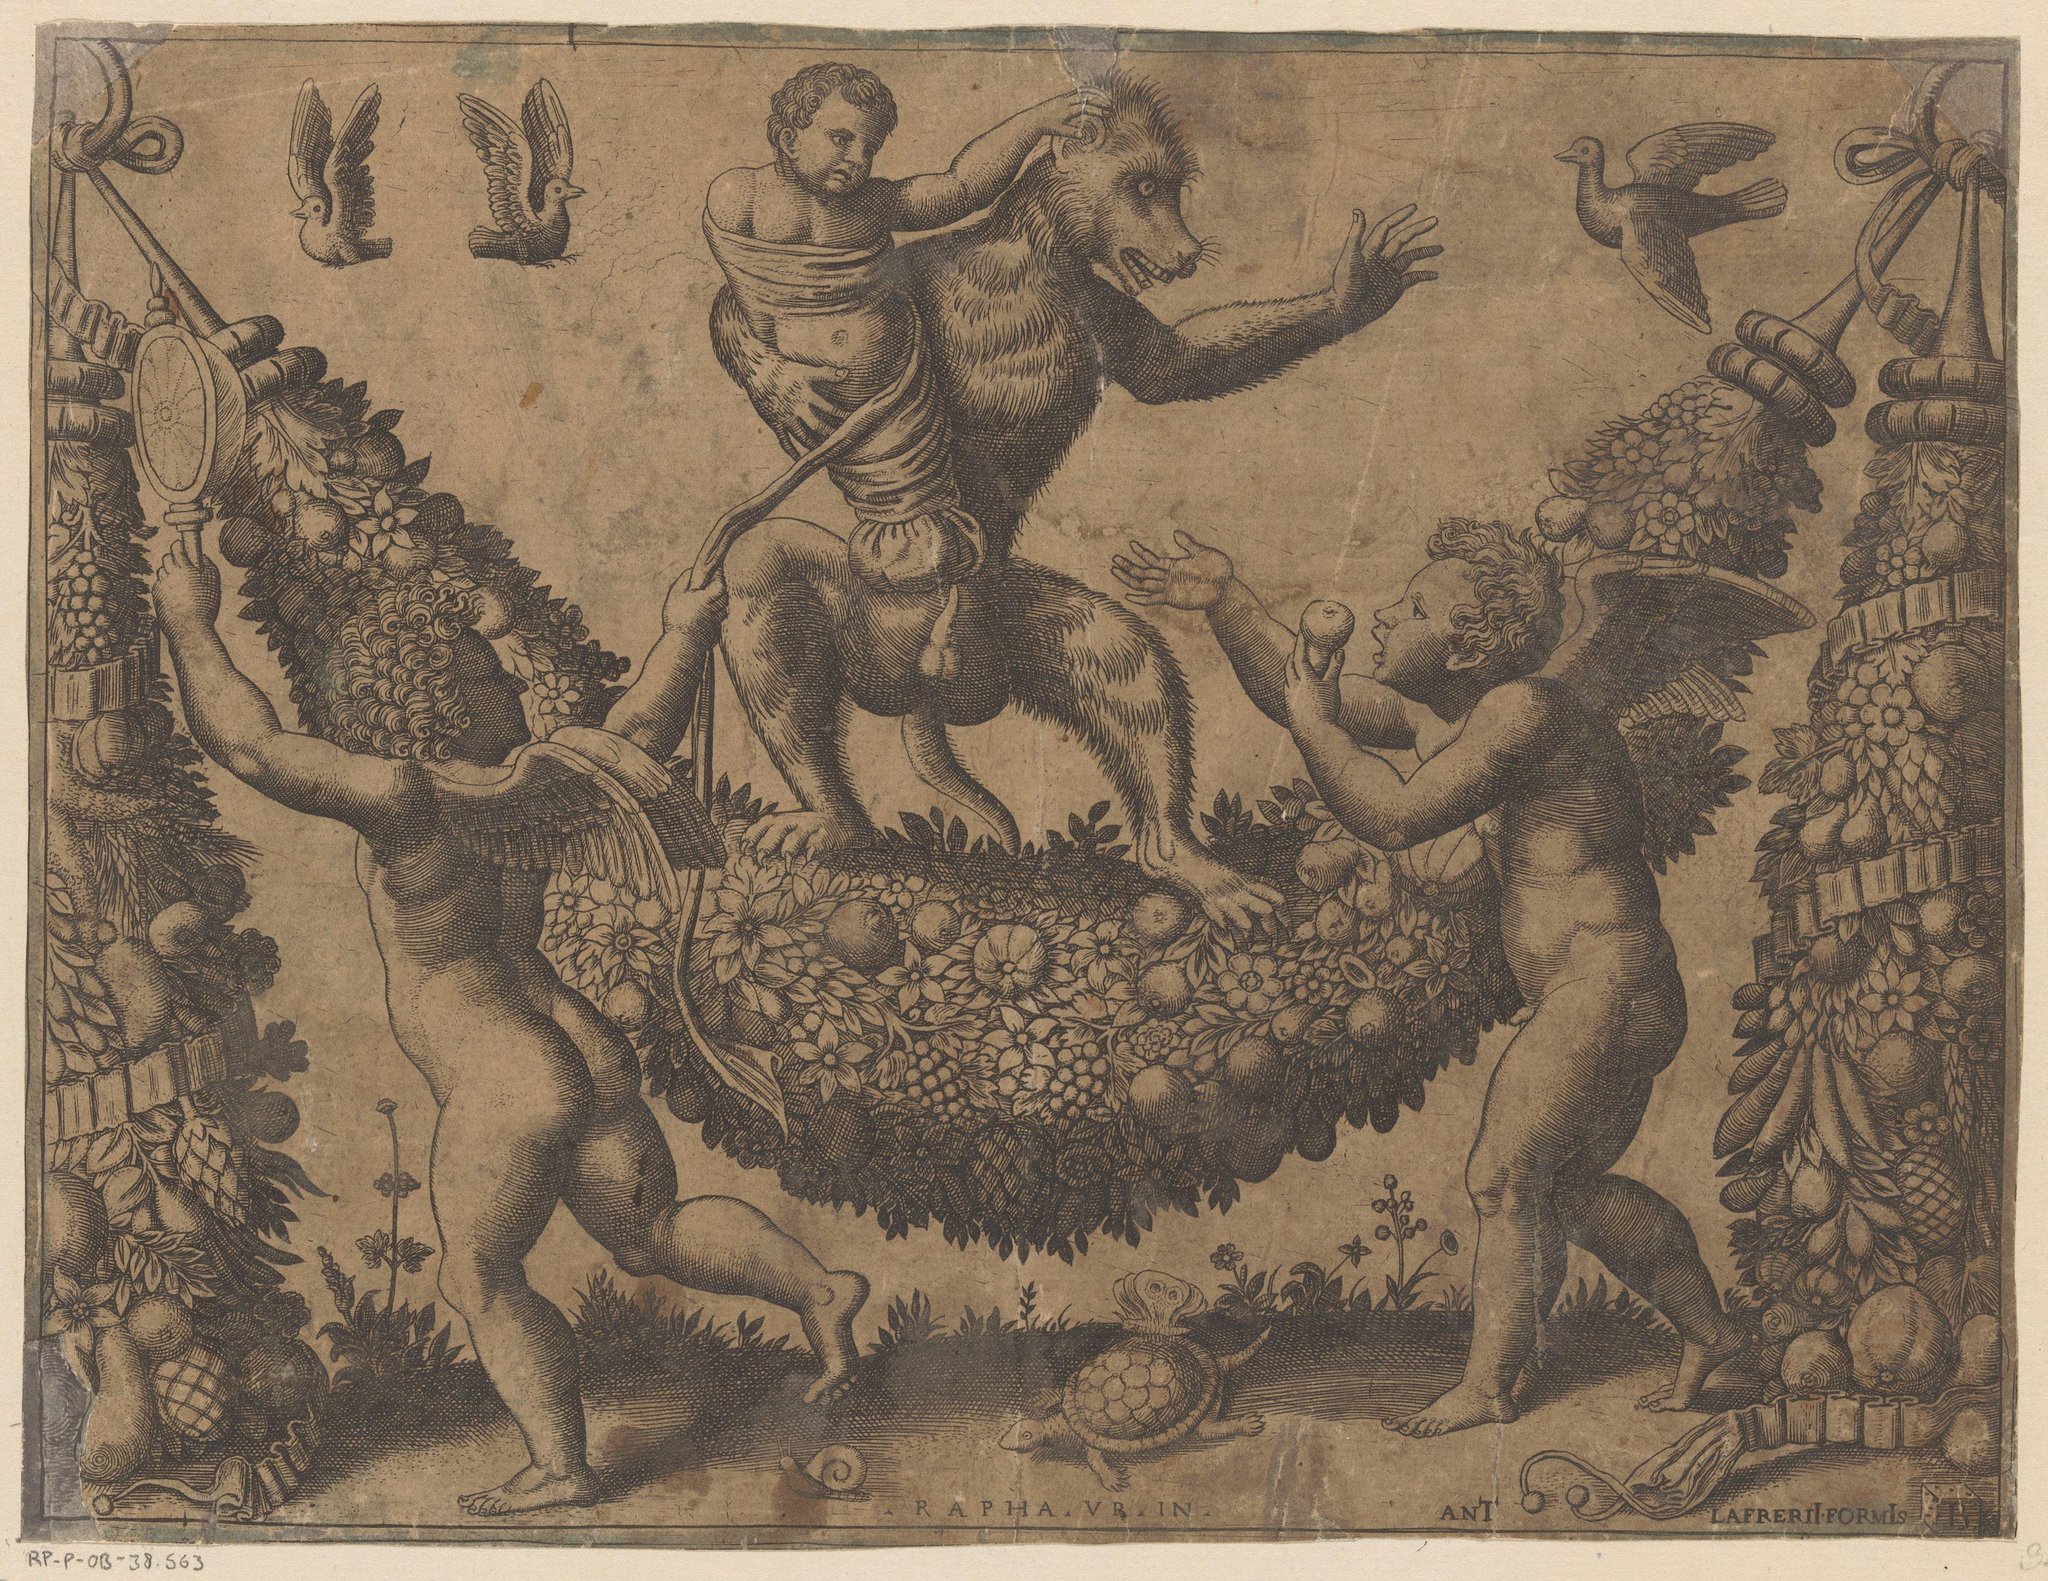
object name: print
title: Tapezzerie de Papa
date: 1530-1560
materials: paper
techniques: engraving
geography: rome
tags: tortoises, turtles, monkeys, apes, rattle ~ acoustic signalling, insects: butterfly, molluscs: snail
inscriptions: collector's mark: Lugt 240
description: Op een grote guirlande staat een aap met een in stof gewikkelde putto. Rechts een putto met een vrucht in de hand en links een putto met een rammelaar. Op de grond een slak, een schildpad en een vlinder.